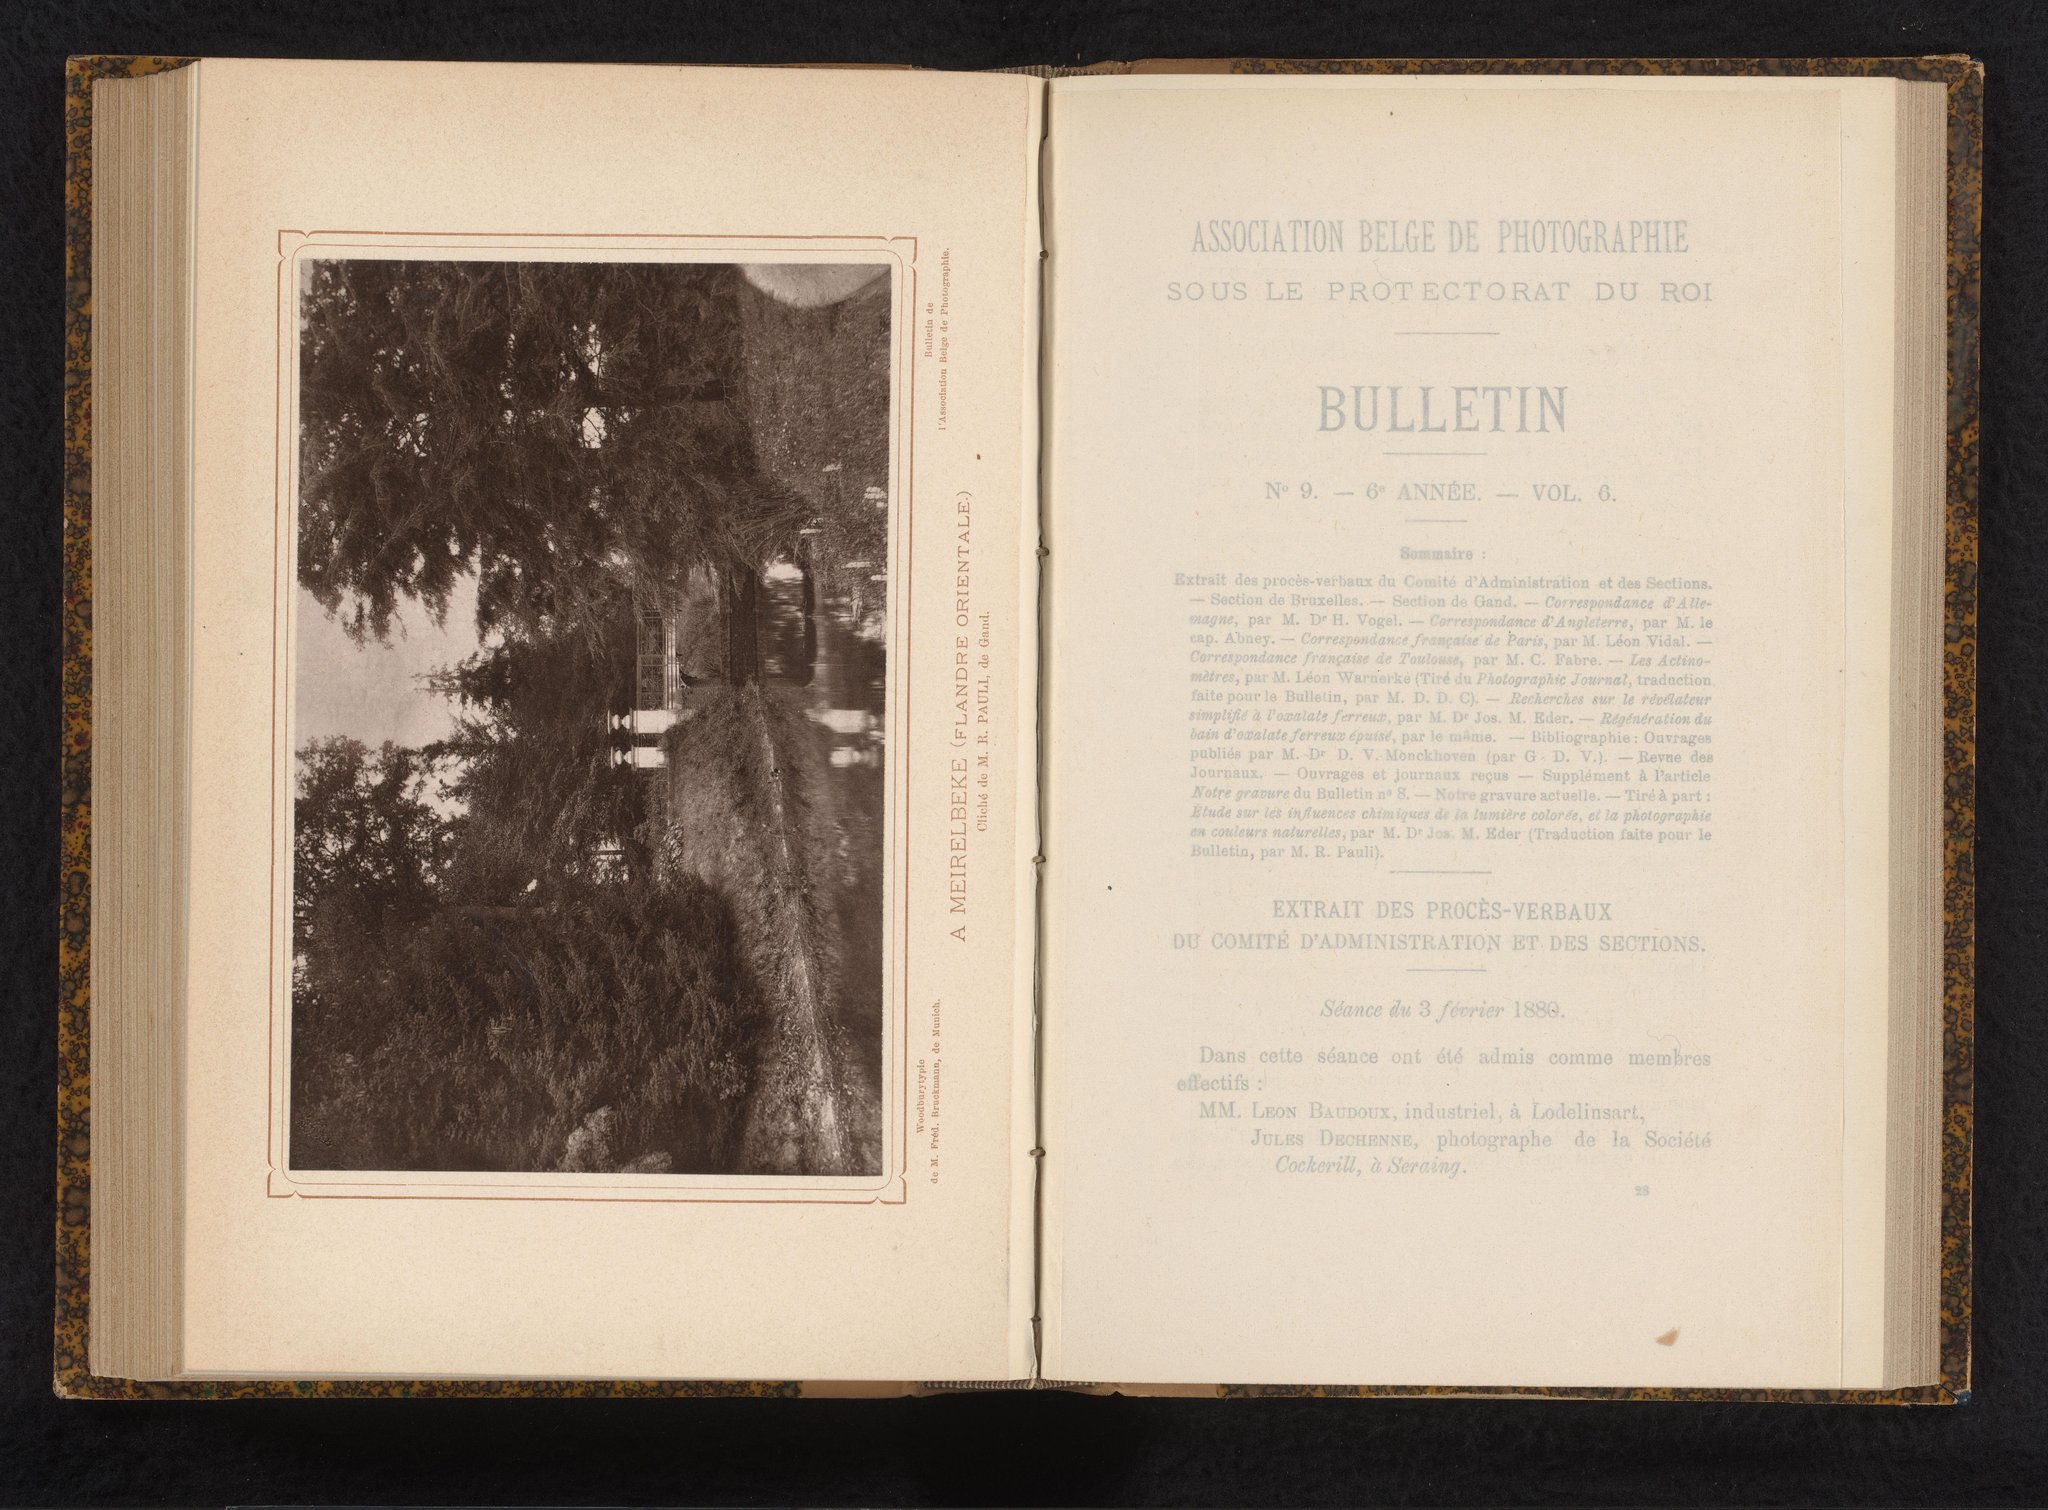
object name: page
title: A Meirelbeke (Flandre Orientale)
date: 1875-1880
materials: cardboard, paper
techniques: woodburytype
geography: merelbeke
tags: park, bridge